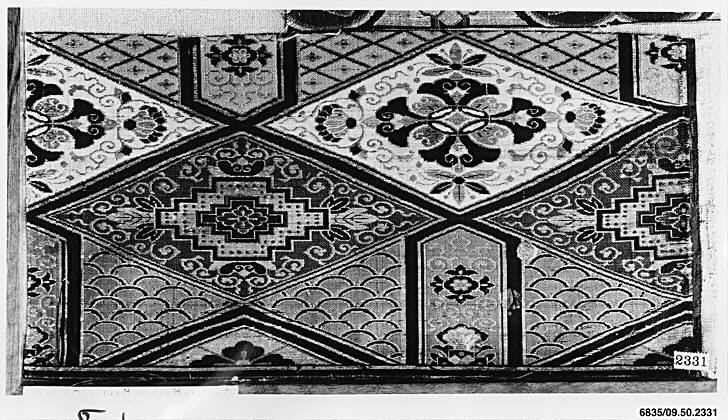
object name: piece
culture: japanese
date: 1615-1868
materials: metal thread, silk